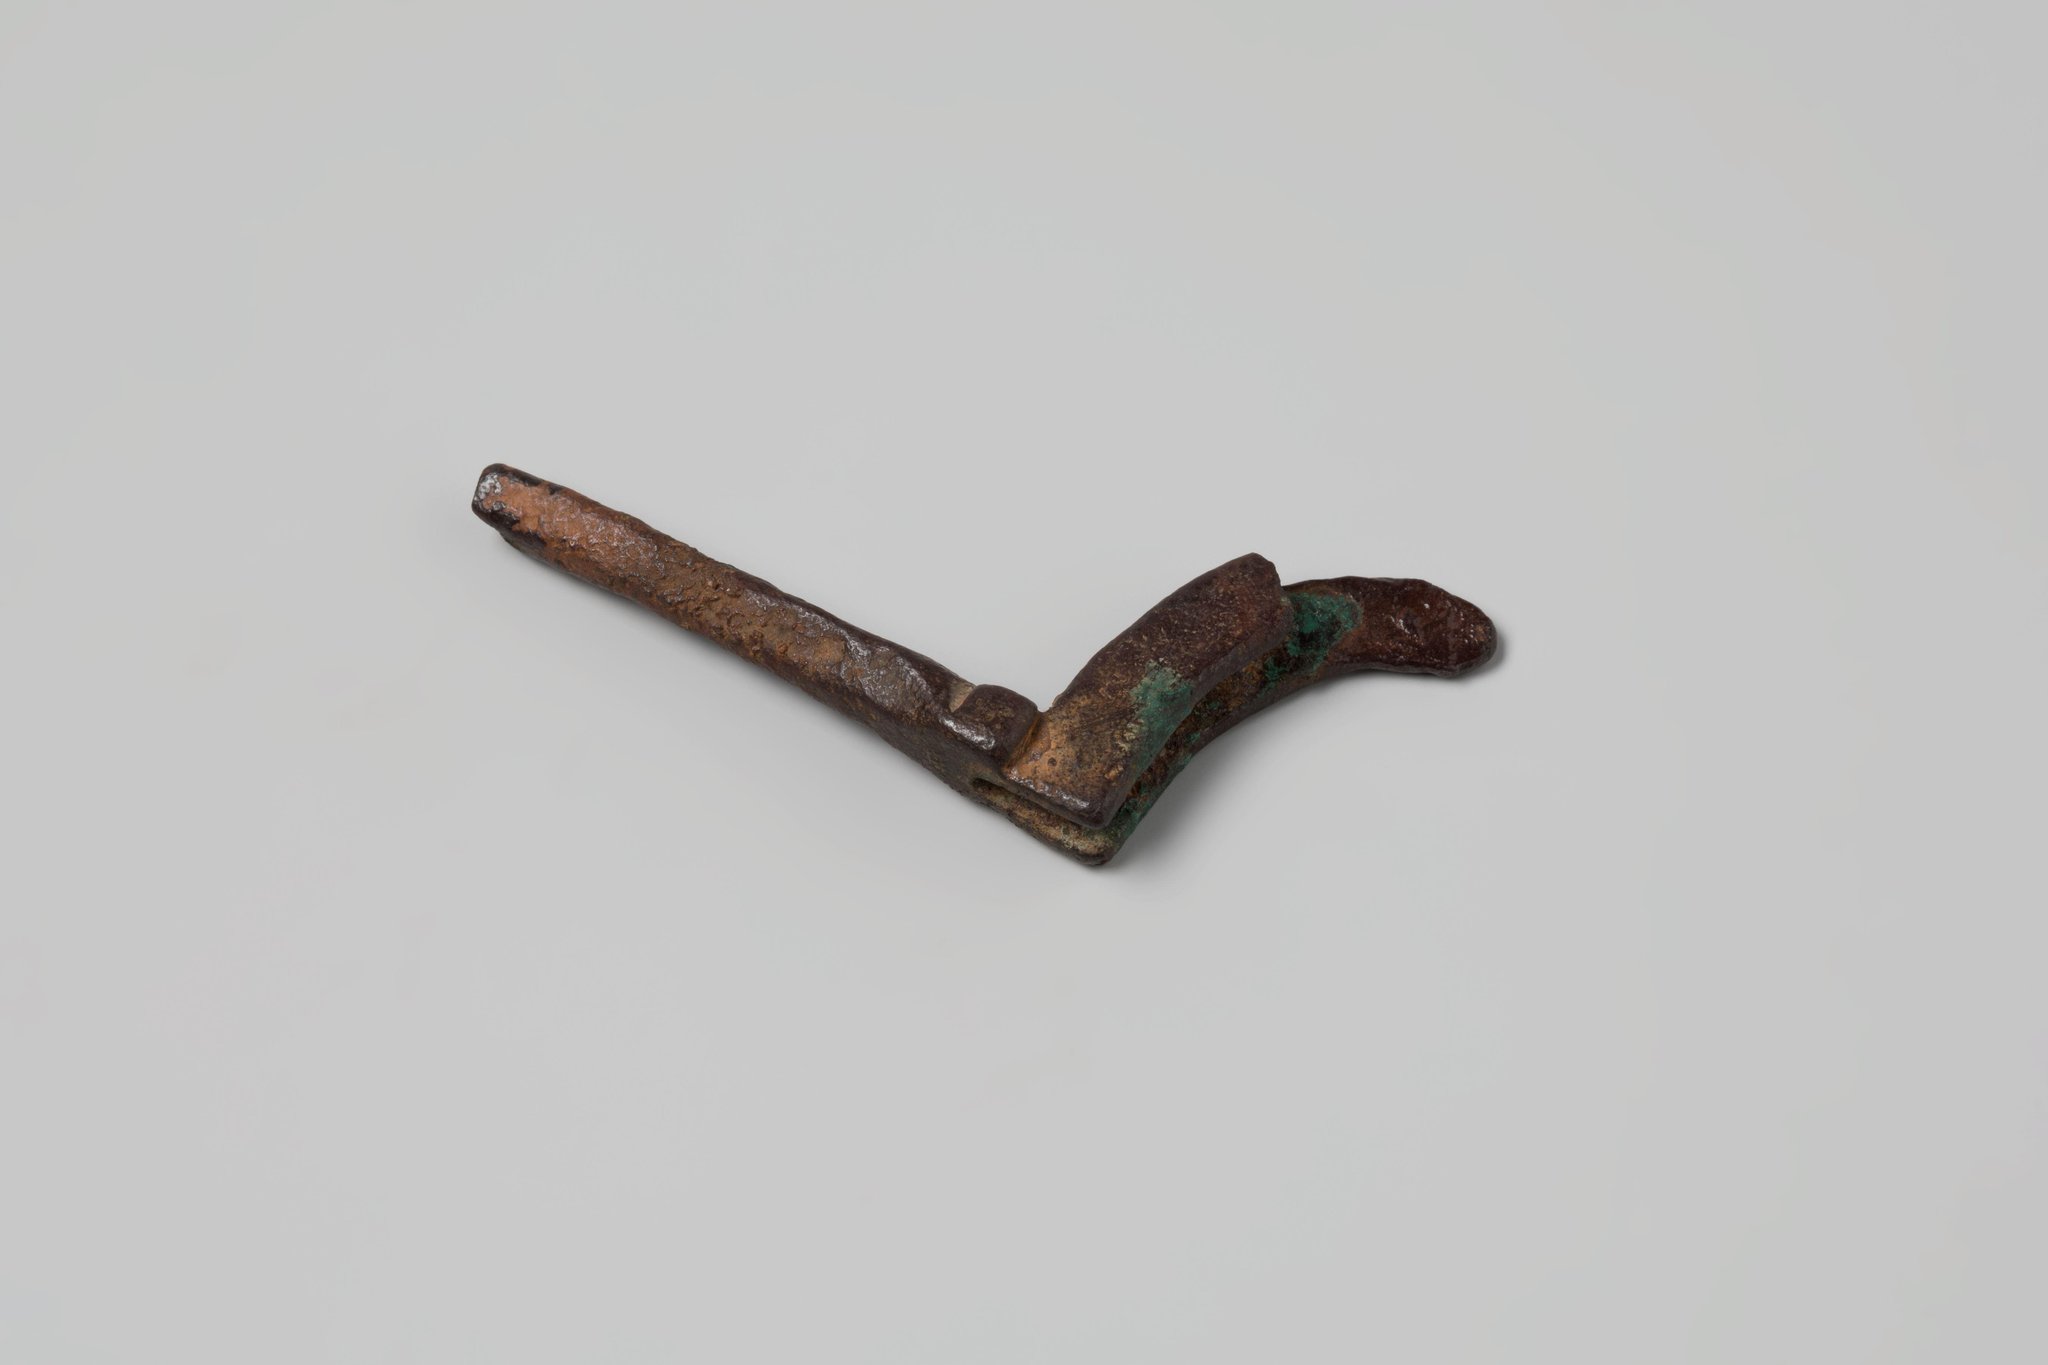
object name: divider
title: Fragment steekpasser uit het wrak van de Oost-Indiëvaarder Hollandia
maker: Anonymous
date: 1700-1743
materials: copper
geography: netherlands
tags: verenigde oostindische compagnie, hollandia (schip), annet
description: Divider; fragment, leg, tapering, three-faceted, with fragm of bifid rings, ends broken off (shape id. NG 1980-27H2926).